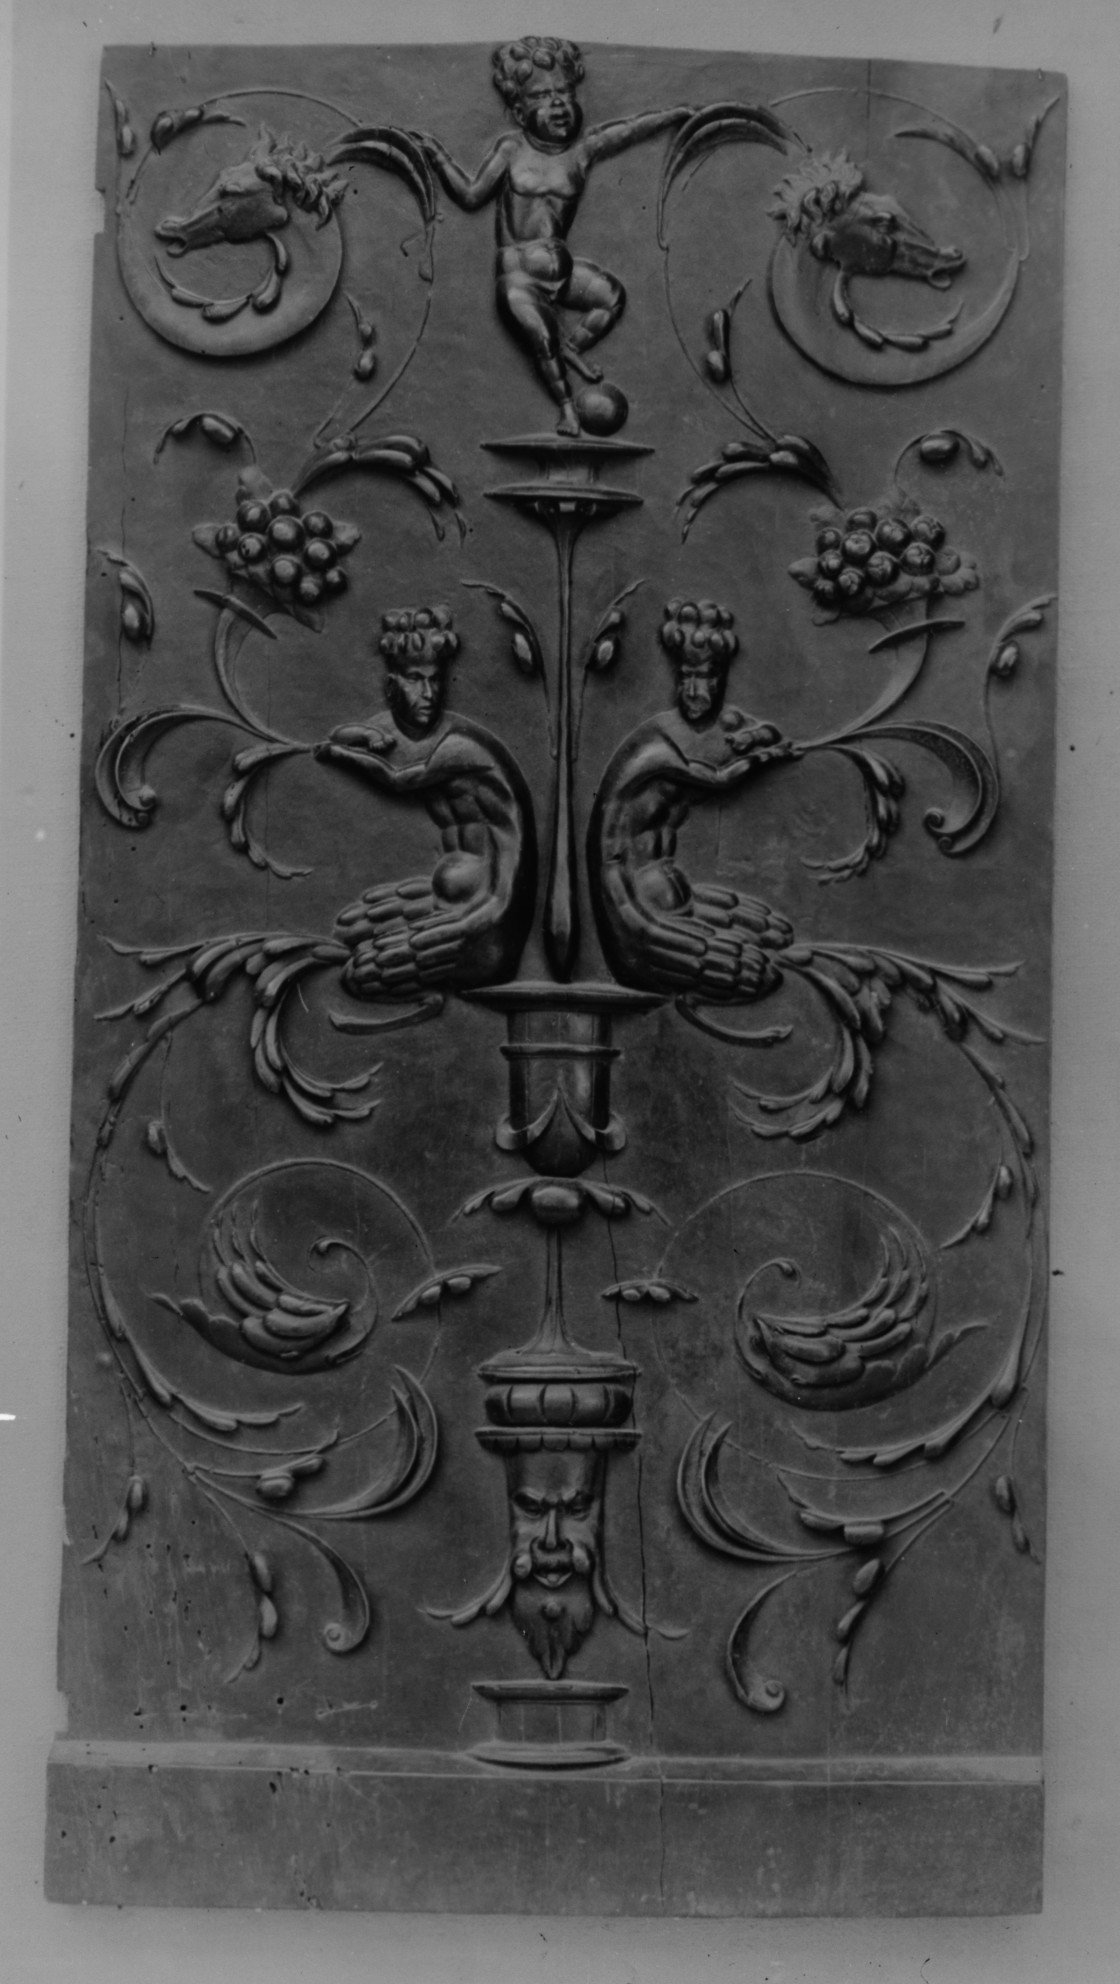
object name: panel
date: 1551-1600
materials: wood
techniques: carving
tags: human figures,faces,horses